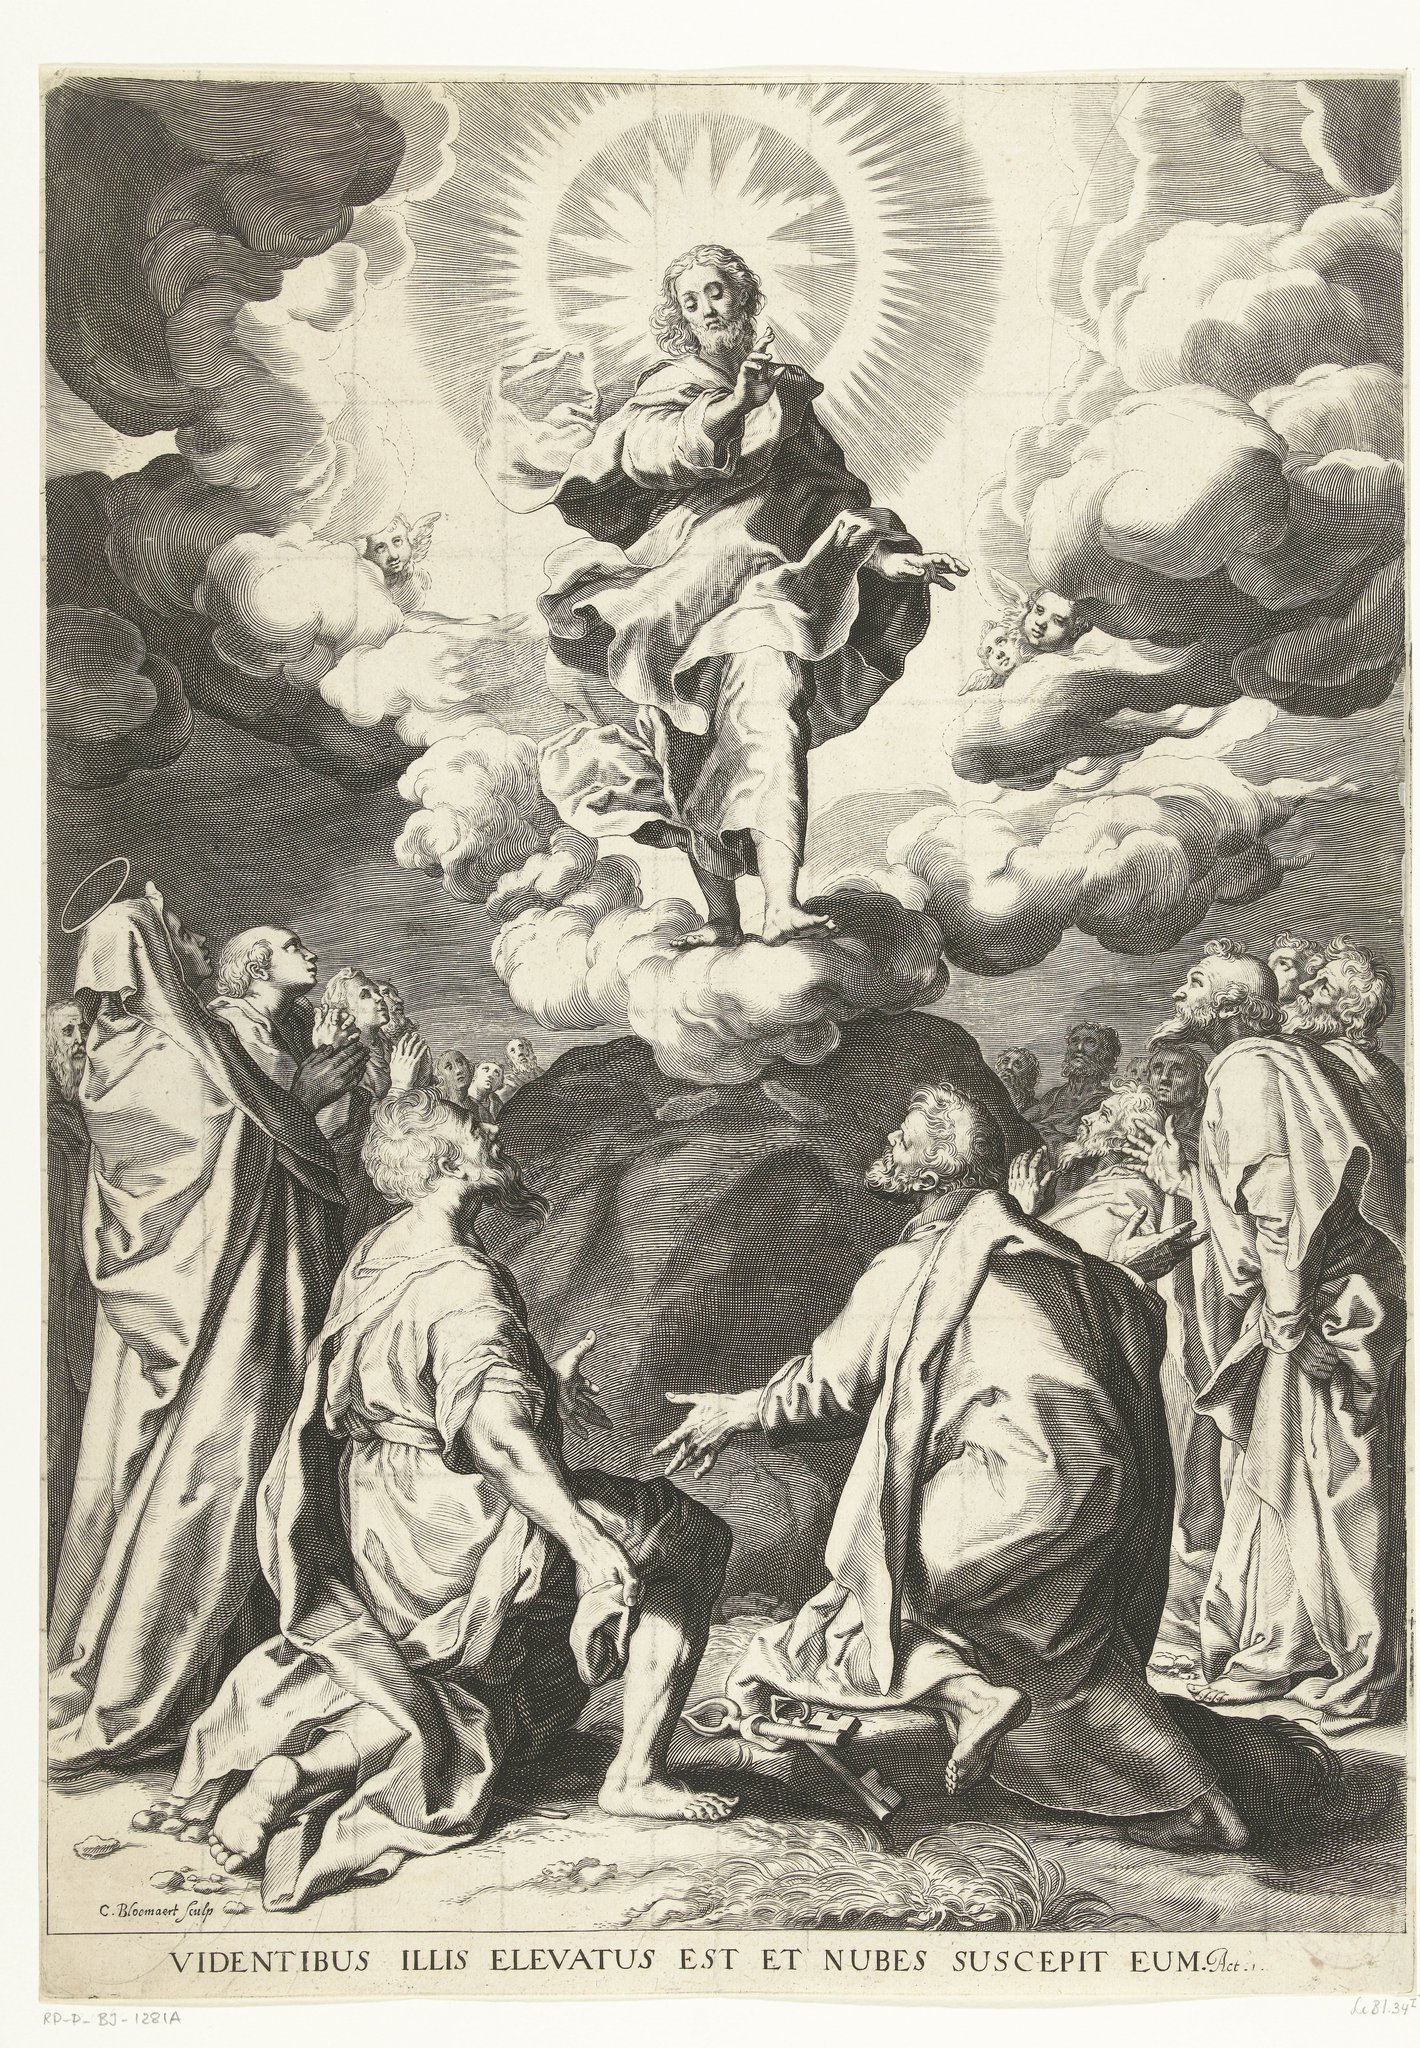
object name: print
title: Hemelvaart van Christus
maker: cornelis bloemaert (ii)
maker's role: draughtsman, print maker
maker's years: 1603-1692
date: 1656-1692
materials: paper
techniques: engraving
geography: rome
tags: christ ascends into heaven; apostles (and mary) beneath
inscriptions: collector's mark: Lugt 240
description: De verschijning van Christus aan de apostelen na zijn opstanding, op het moment dat hij in een wolk naar de hemel wordt gevoerd.Onder de apostelen bevindt zich ook Maria.